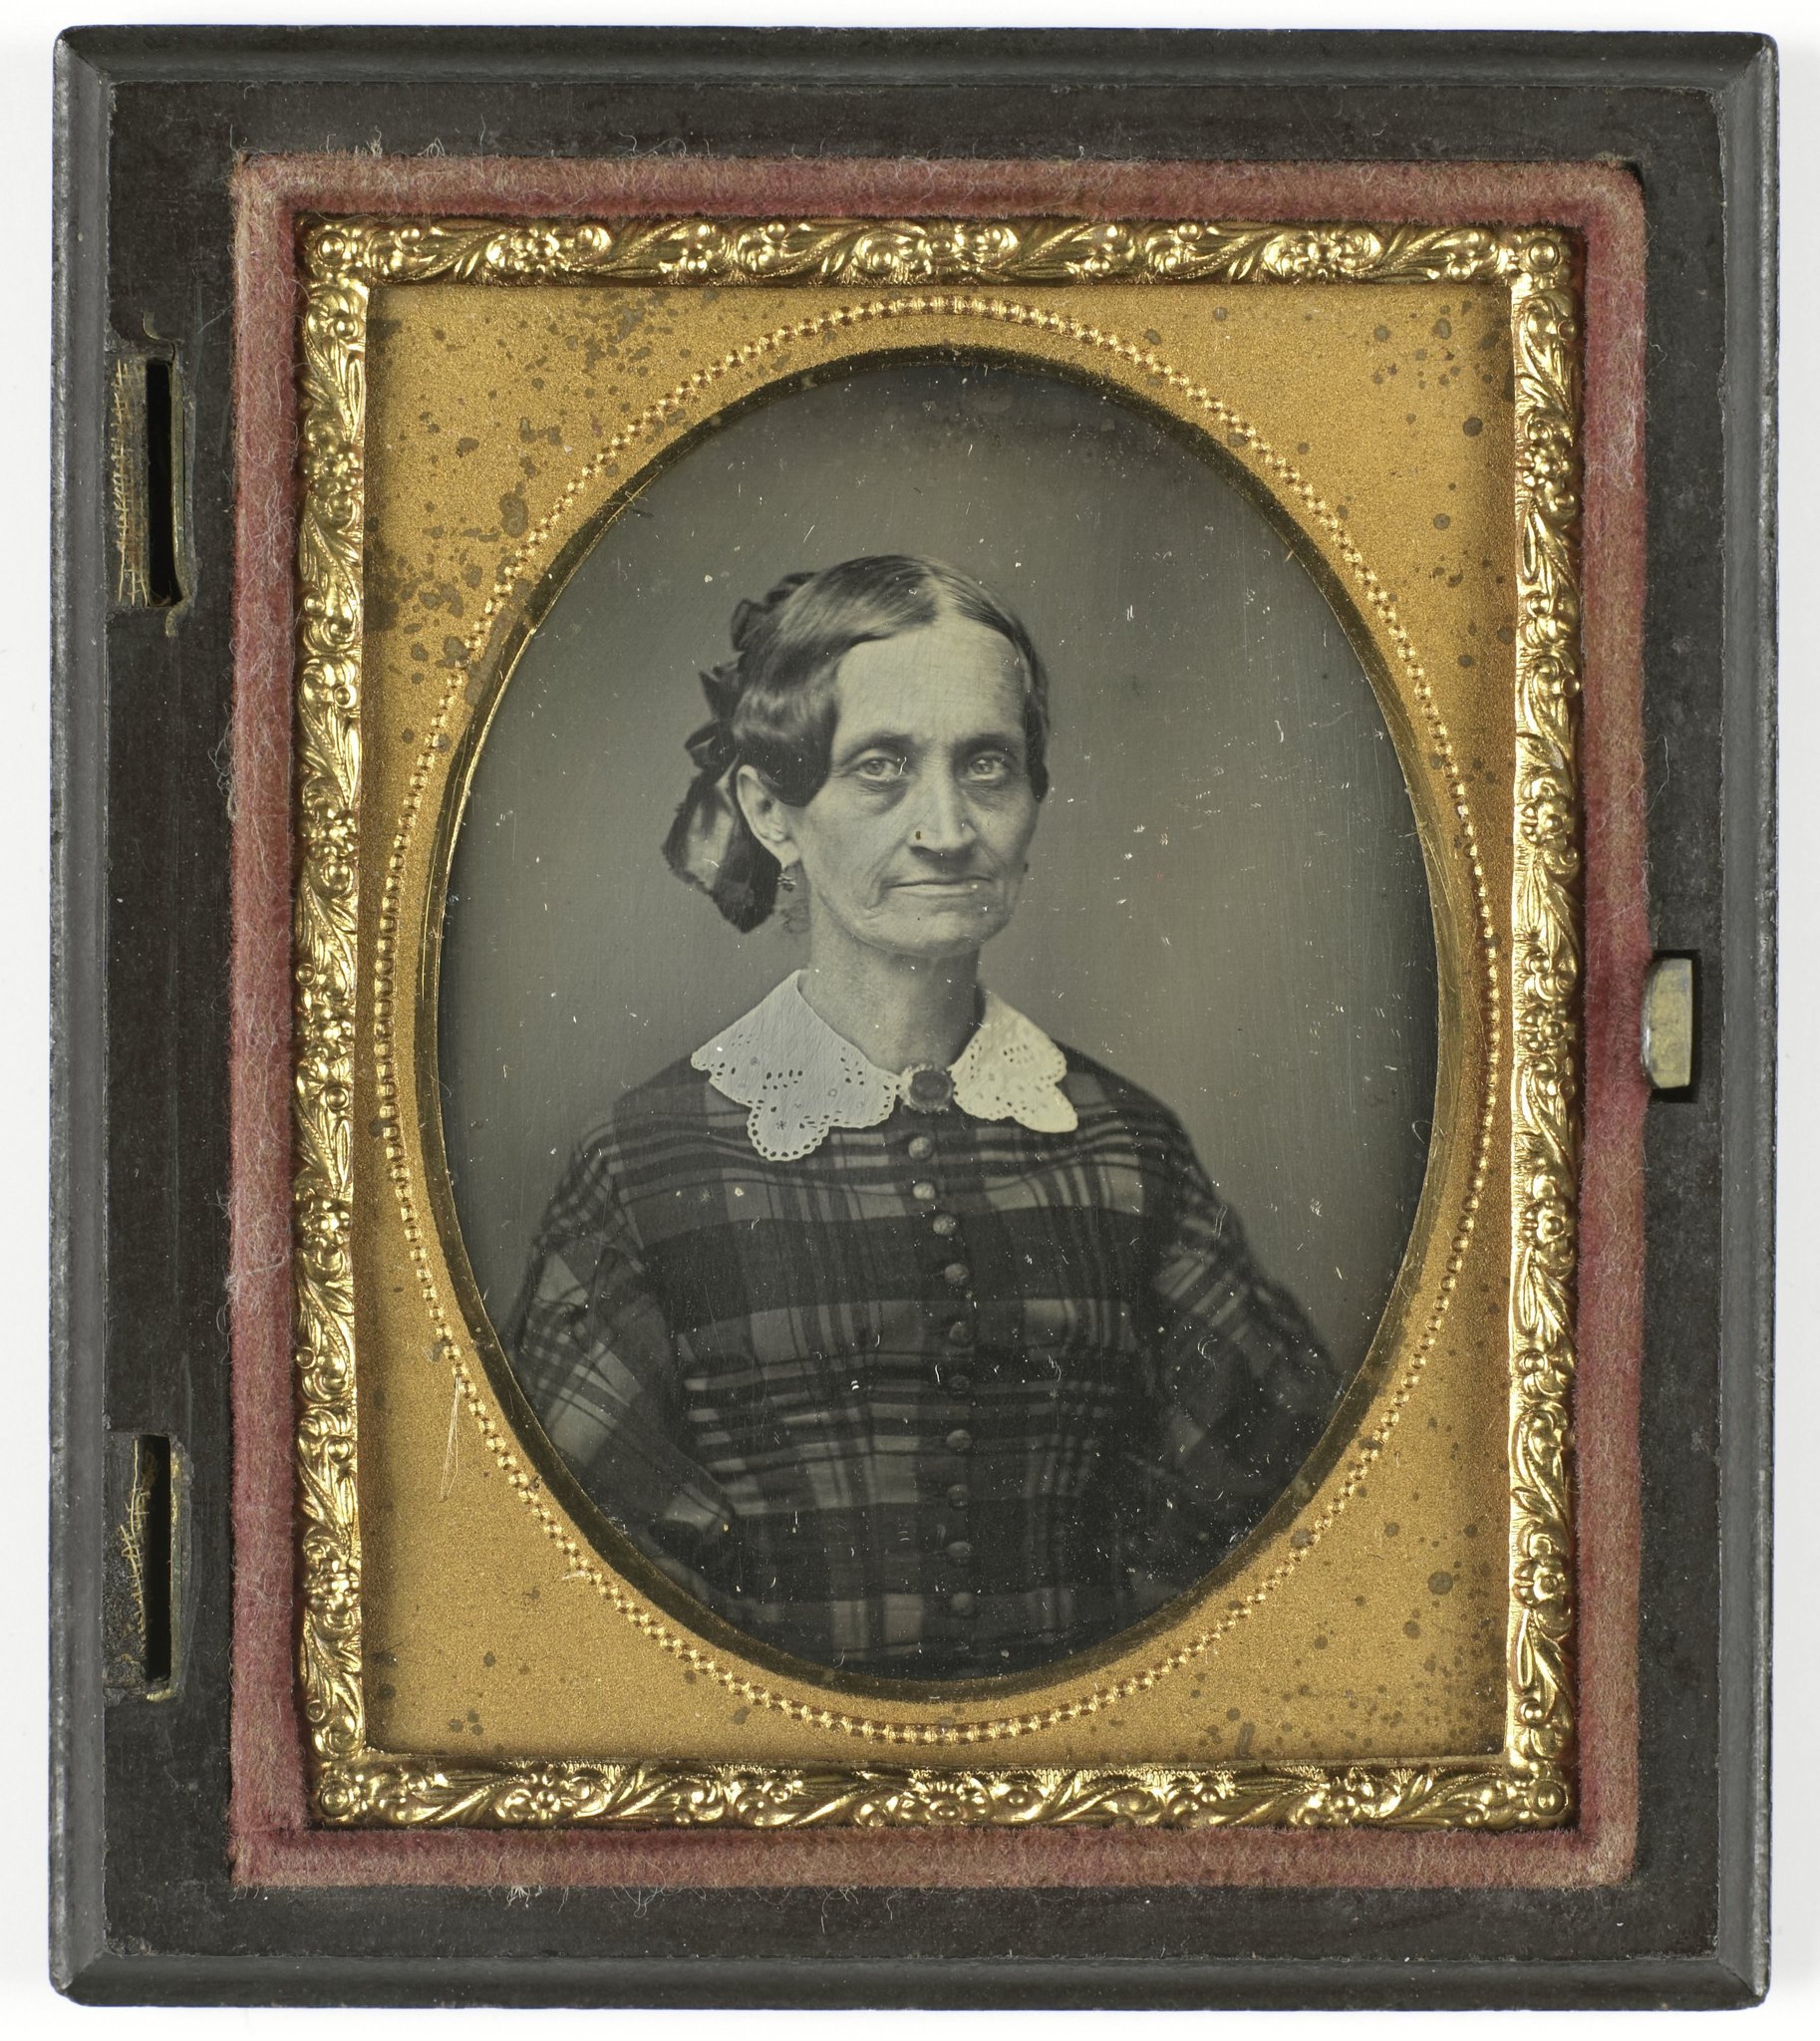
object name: photograph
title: Portret van een onbekende vrouw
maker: Anonymous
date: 1840-1860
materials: copper, glass, plastic, velvet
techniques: daguerreotype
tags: adult woman, historical persons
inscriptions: inscription: ‘Daguerreotype uit Mass. U.S.A/ 1856/ [...] patent’